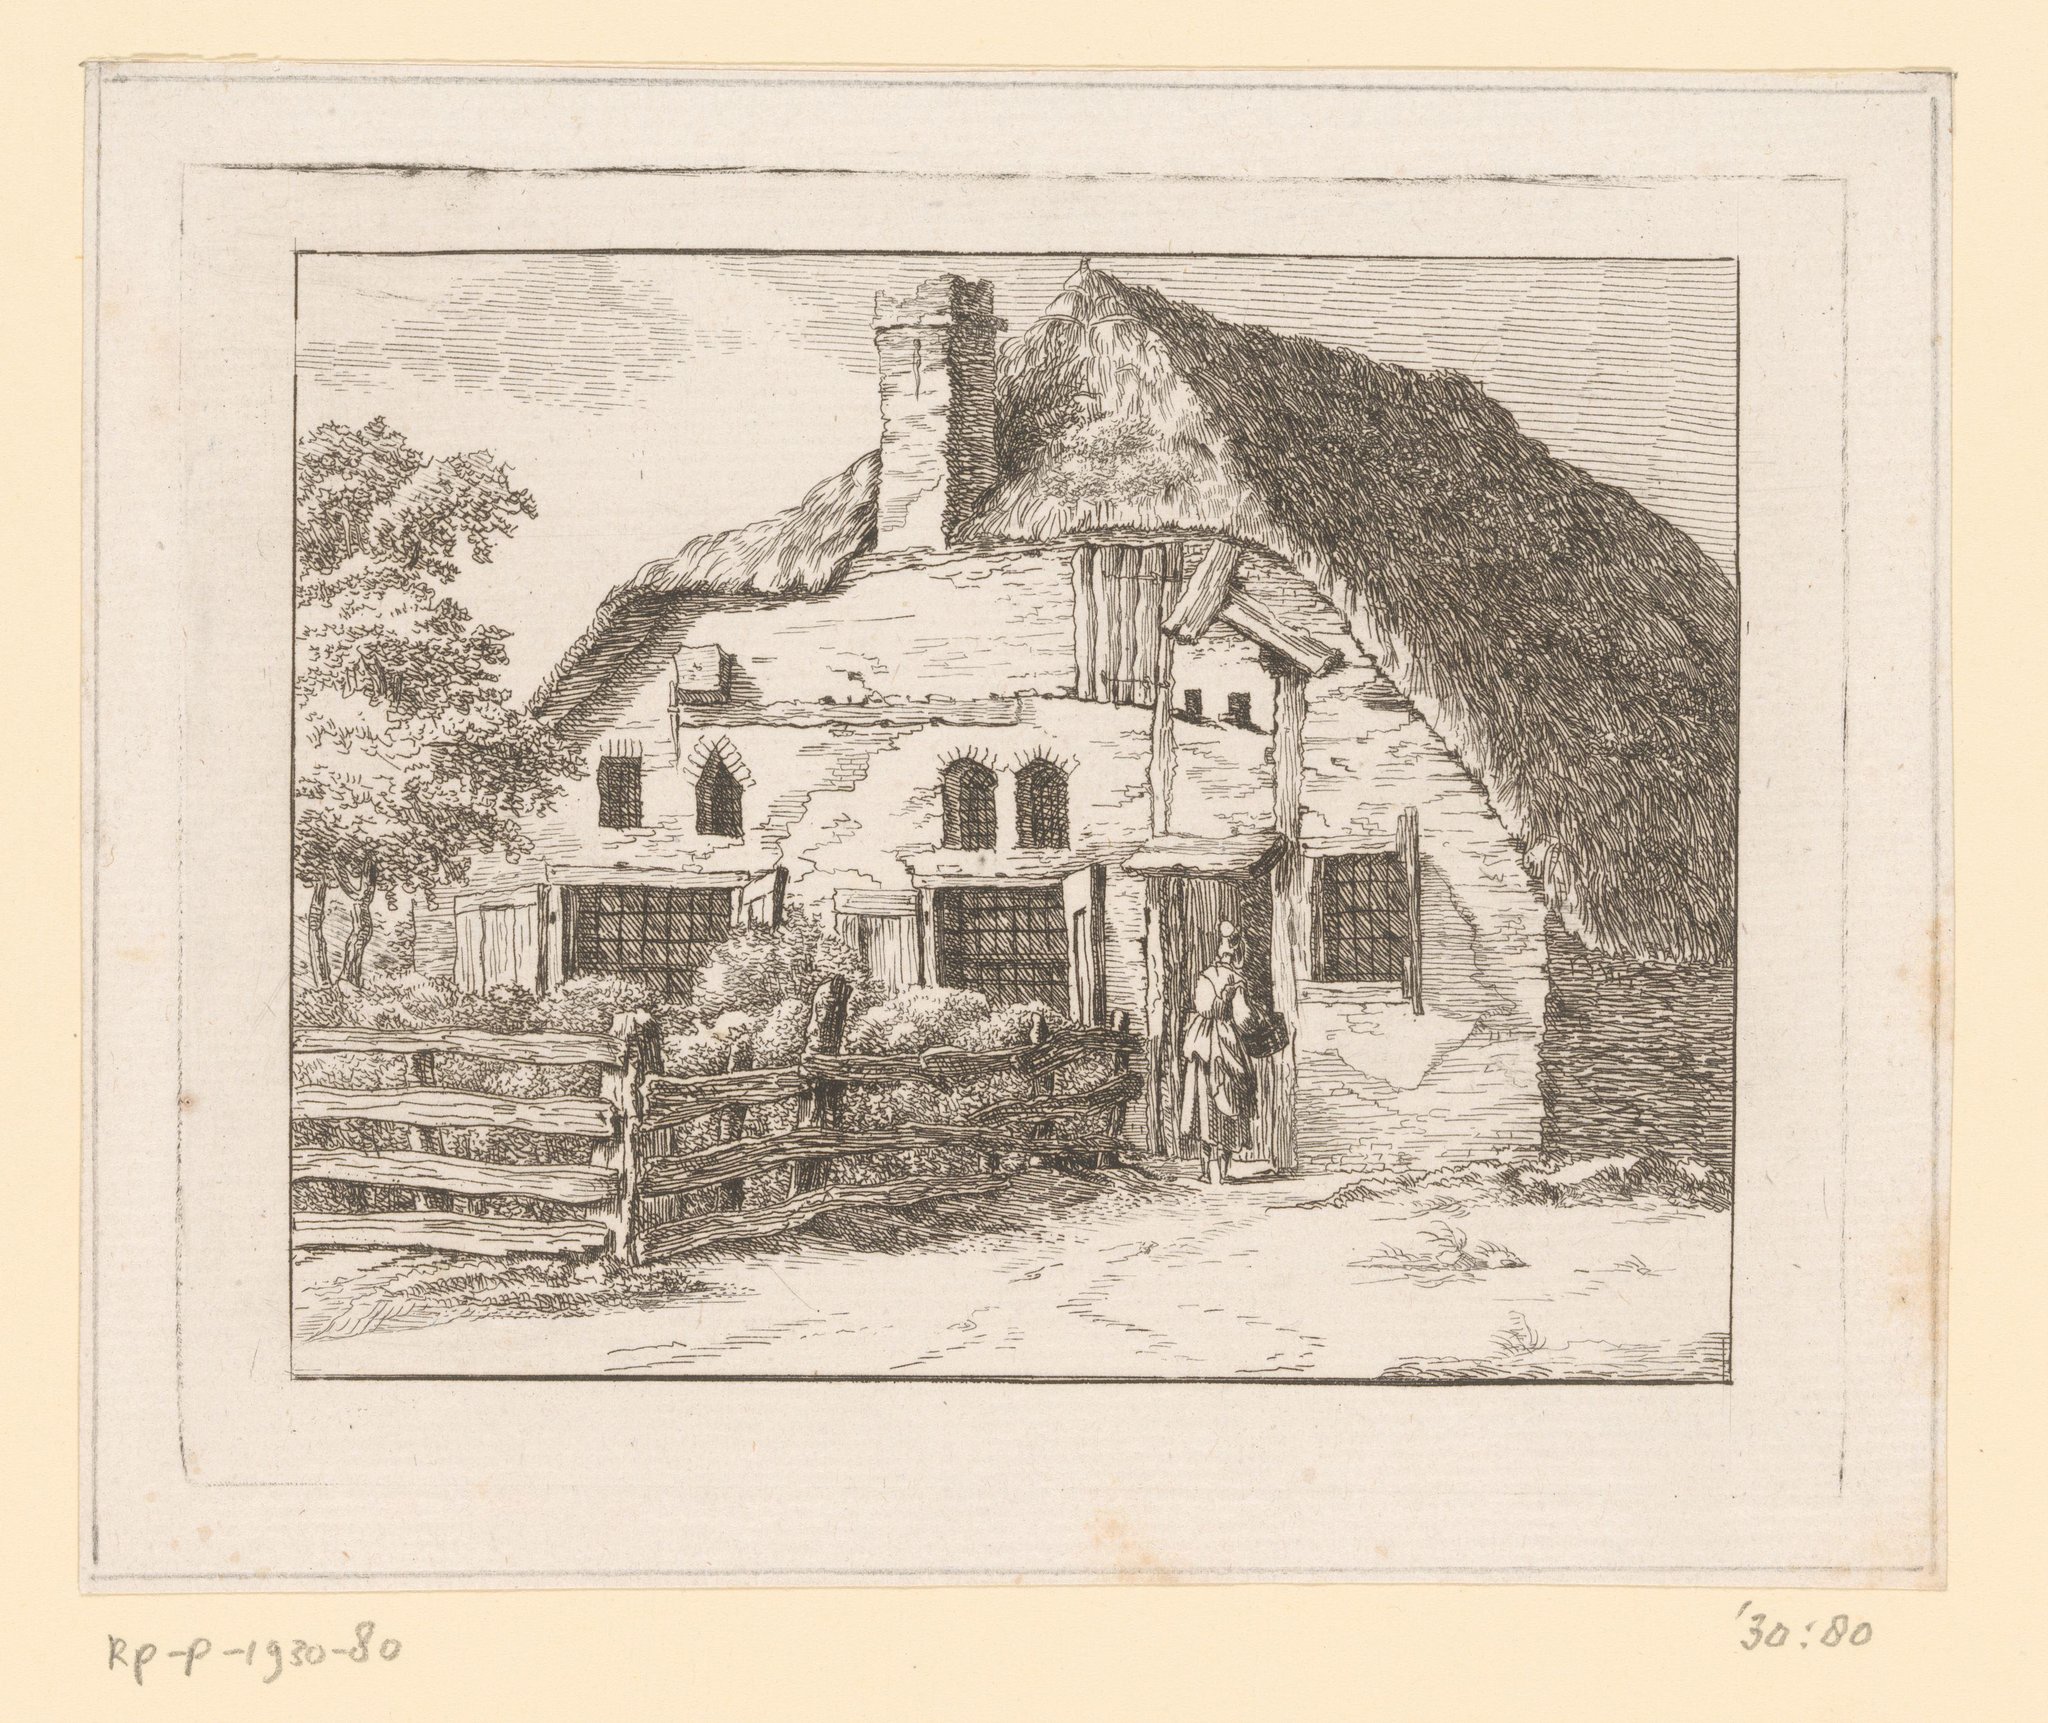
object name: print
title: Vrouw met een mand voor een huis te Staphorst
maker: anthonie van den bos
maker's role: draughtsman, print maker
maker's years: 1763-1838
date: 1773-1838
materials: paper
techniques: etching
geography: netherlands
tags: farm (building)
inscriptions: collector's mark: Lugt 2233, inscription: ‘Shorst in het Landt Drenthe’